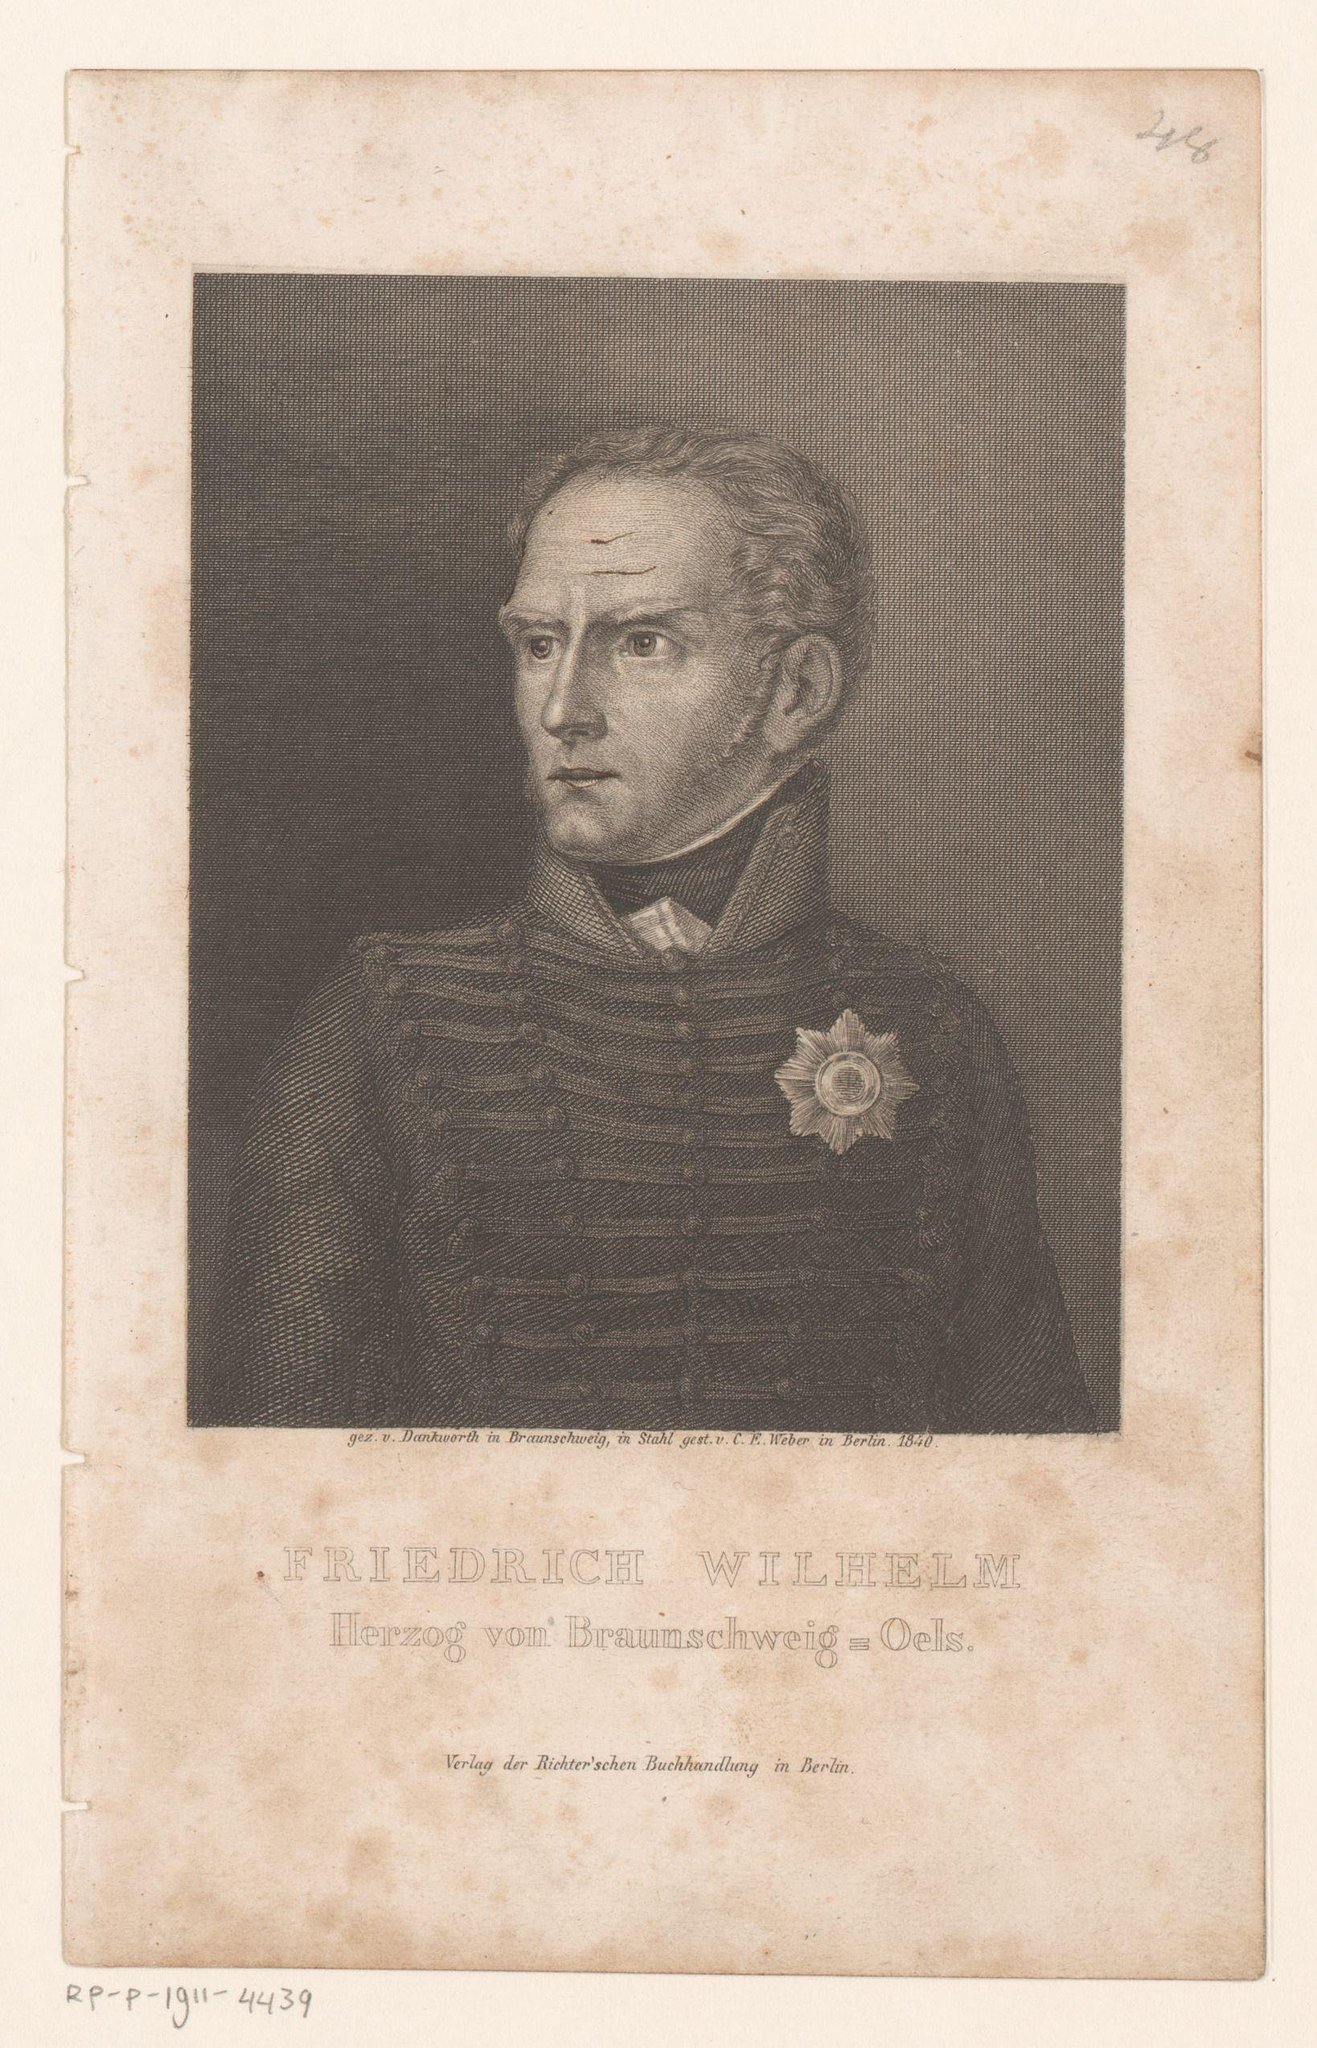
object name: print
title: Portret van Frederik Willem van Brunswijk-Lüneburg-Oels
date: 1840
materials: paper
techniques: engraving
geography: berlin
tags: historical persons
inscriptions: collector's mark: Lugt 2228